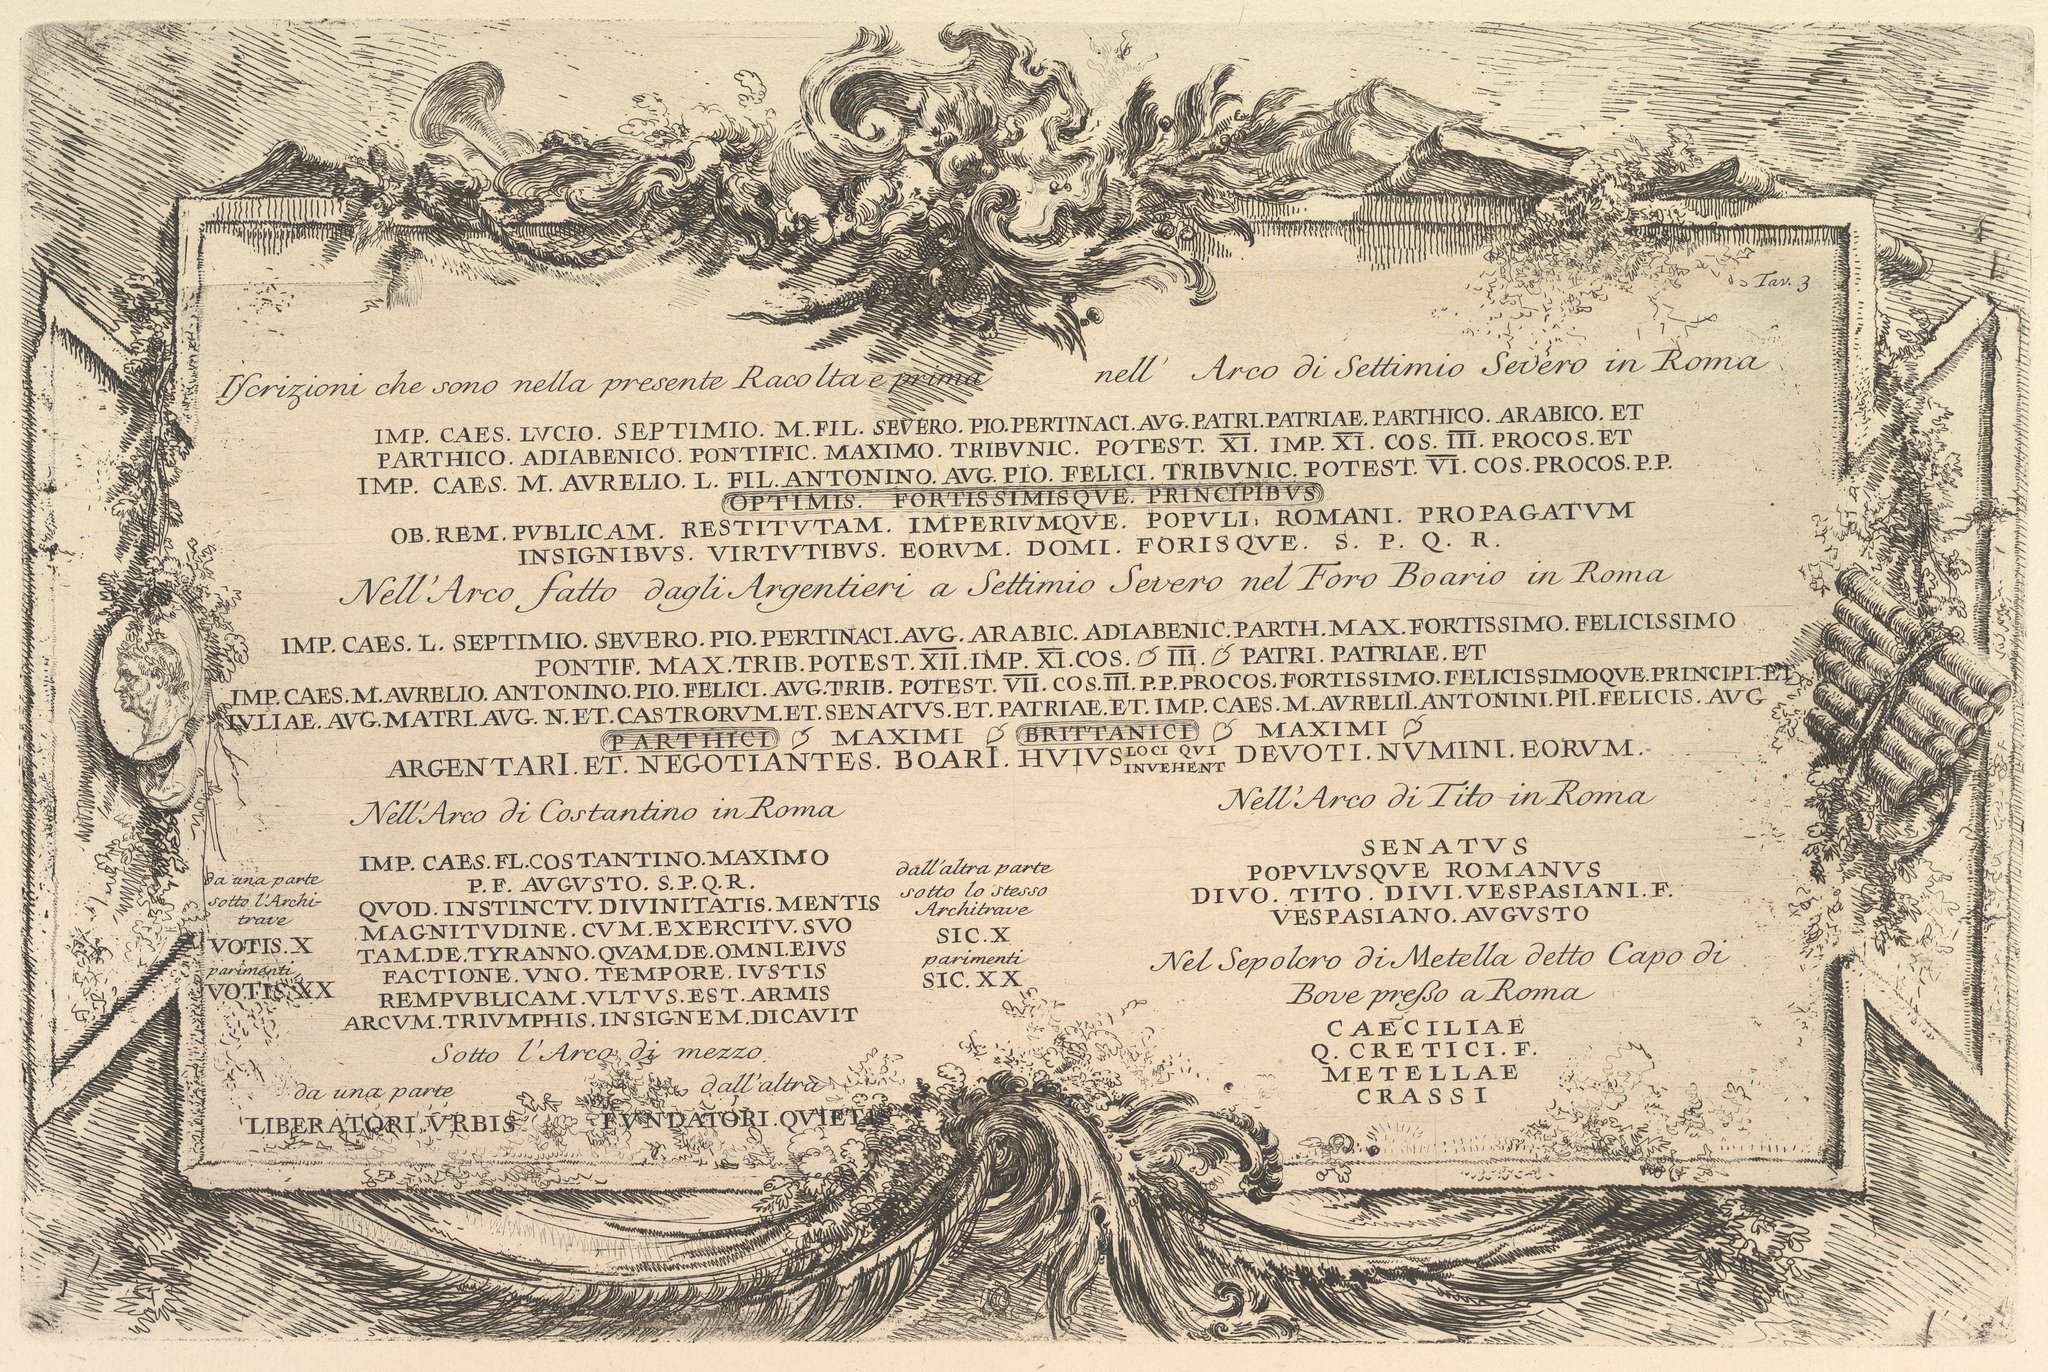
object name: print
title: Plate 3: Inscriptions on Antiquities outside Rome with Index of Plates, from "Antichità Romane de' Tempi della Repubblica, e de' primi Imperatori"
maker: giovanni battista piranesi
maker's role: artist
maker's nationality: italian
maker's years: 1720-1778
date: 1748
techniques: etching